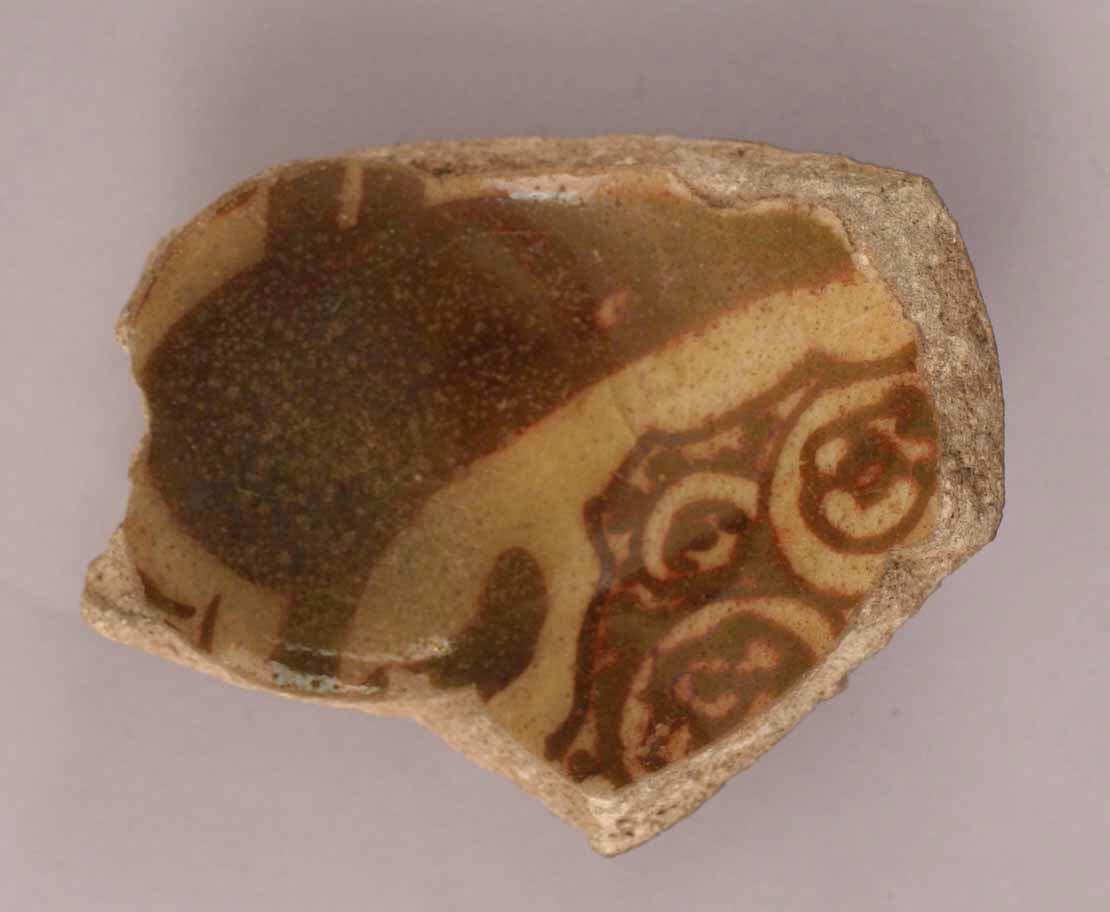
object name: ceramic fragment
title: Fragment of Dish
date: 1001-1200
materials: stonepaste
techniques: glazing, luster painting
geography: syria